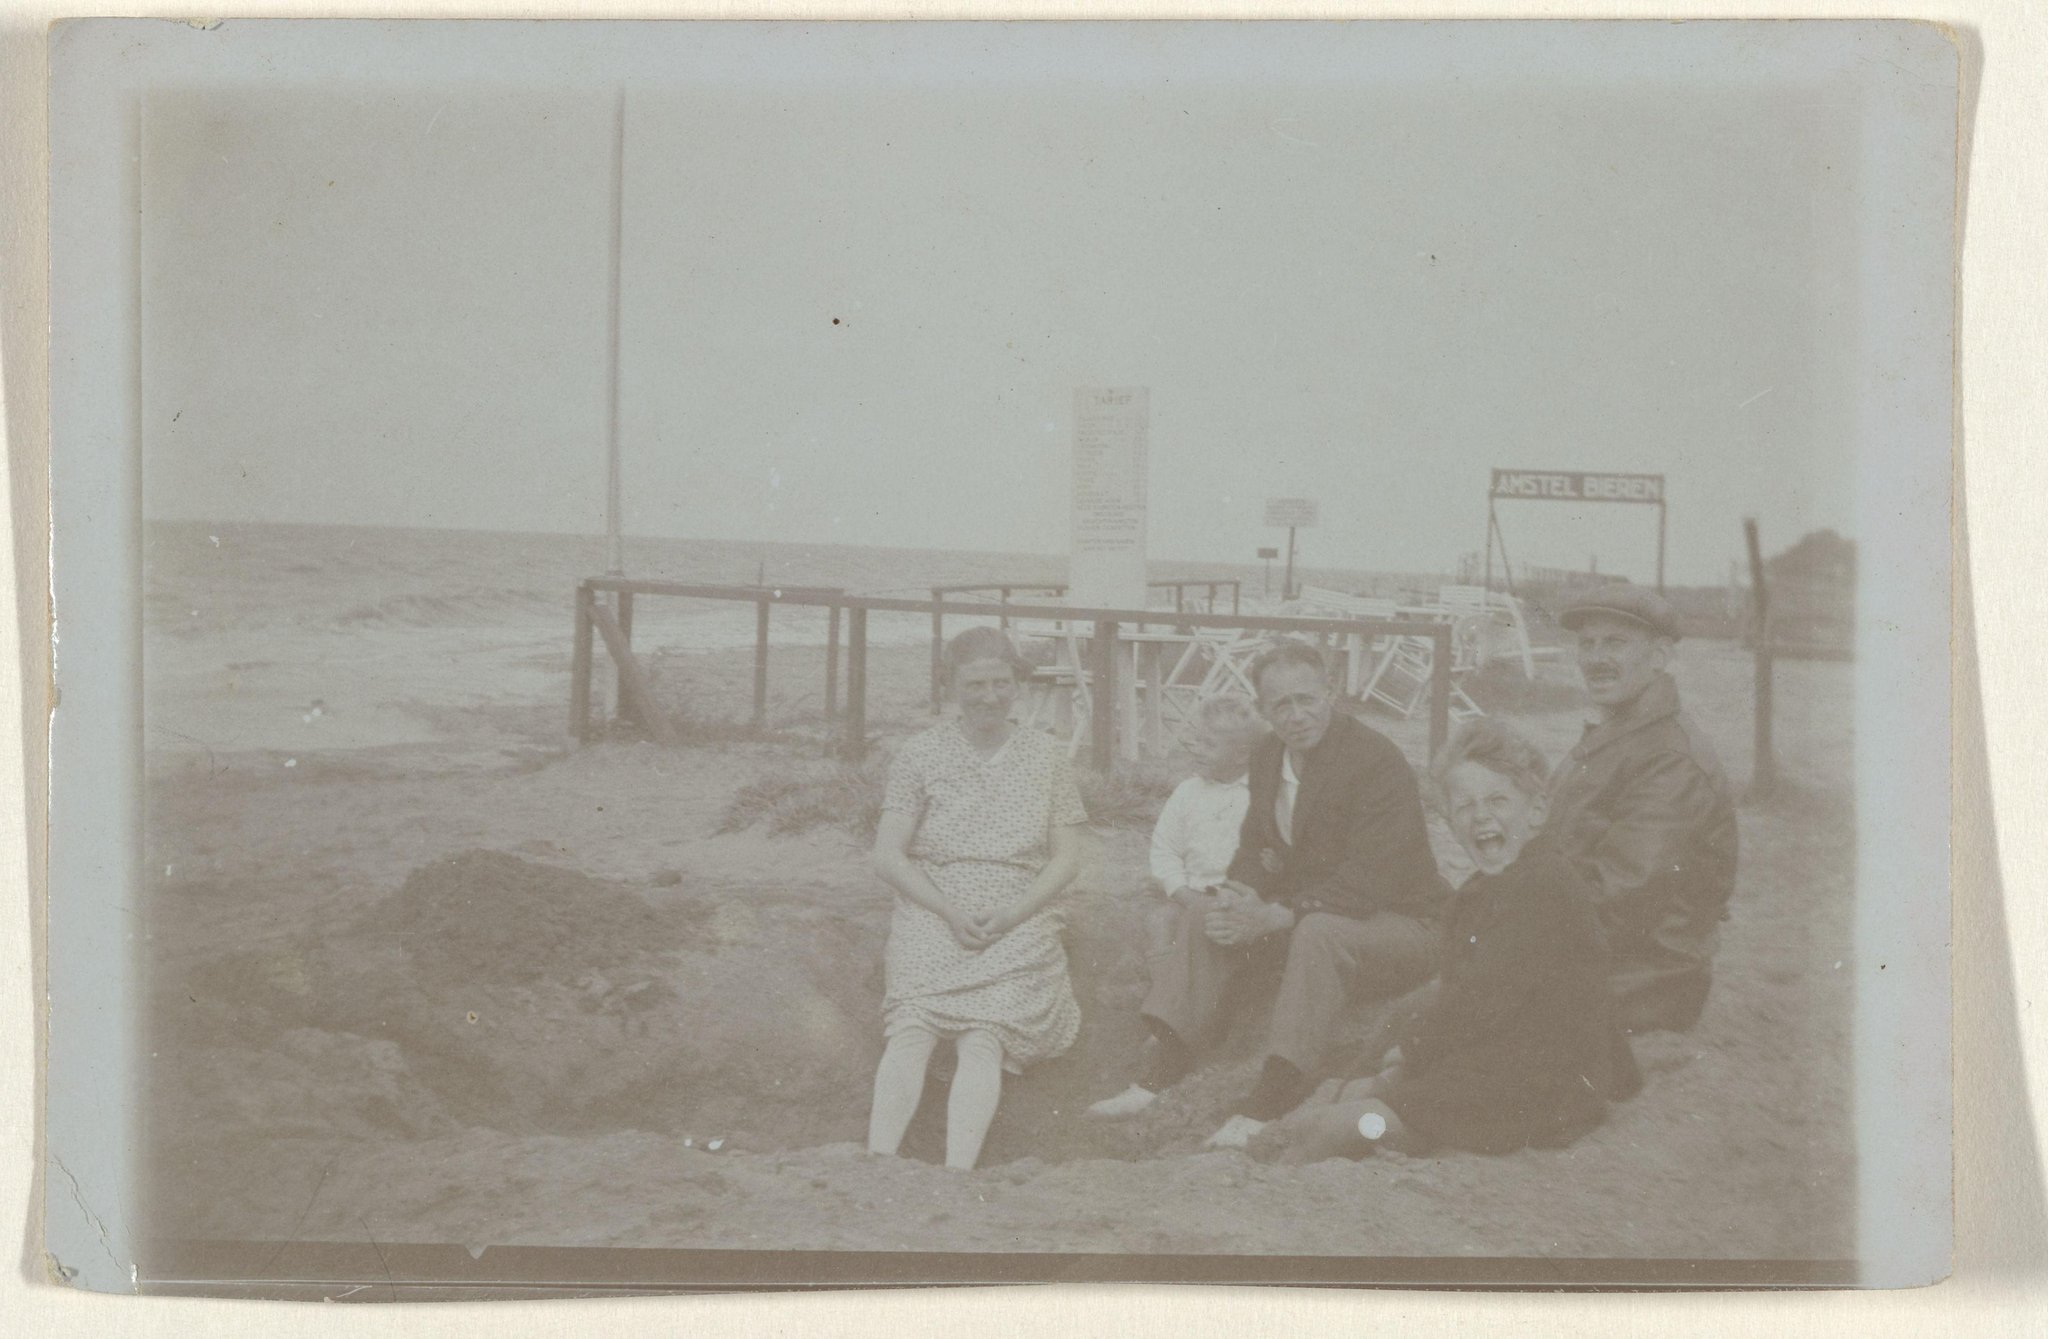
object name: photograph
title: Vijf mensen aan het strand van Valkeveen, waaronder Catharina Maria Groennou en Daan en Ben Ochse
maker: Anonymous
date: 1930-1950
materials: paper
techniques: collodion silver print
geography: valkeveen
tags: beach (as place of recreation)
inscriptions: inscription: ‘AB’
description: Portret van vijf mensen zittend op een strand aan de rand van een kuil (Vinkeveen?).